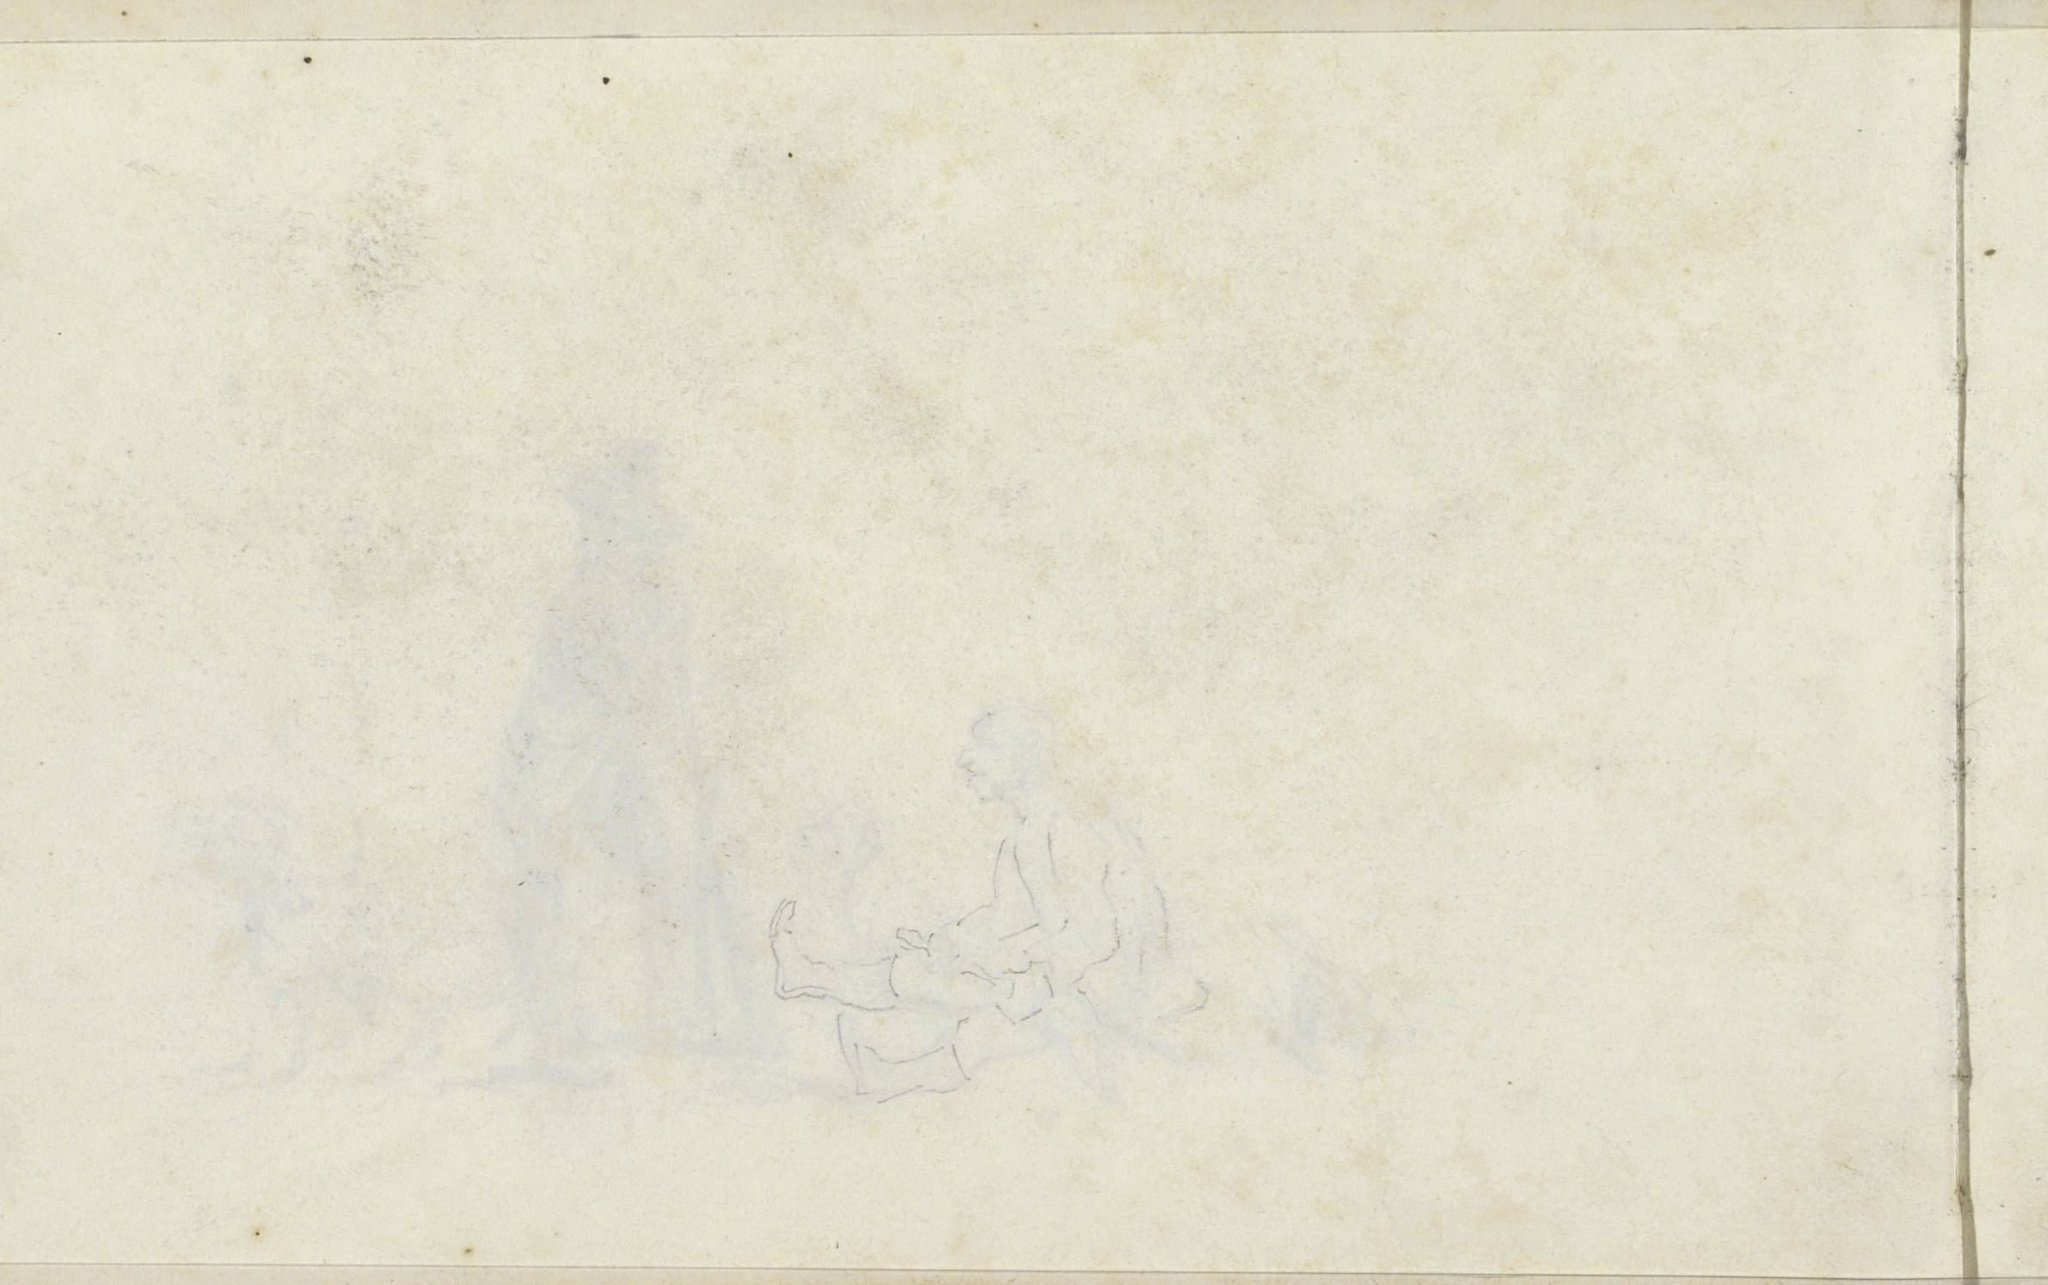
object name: sketchbook leaf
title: Zittende man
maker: johannes tavenraat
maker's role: draughtsman, painter, print maker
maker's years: 1809-1881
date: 1843-1844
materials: paper, pencil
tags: sitting figure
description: Blad 9 verso uit een schetsboek met 38 bladen.